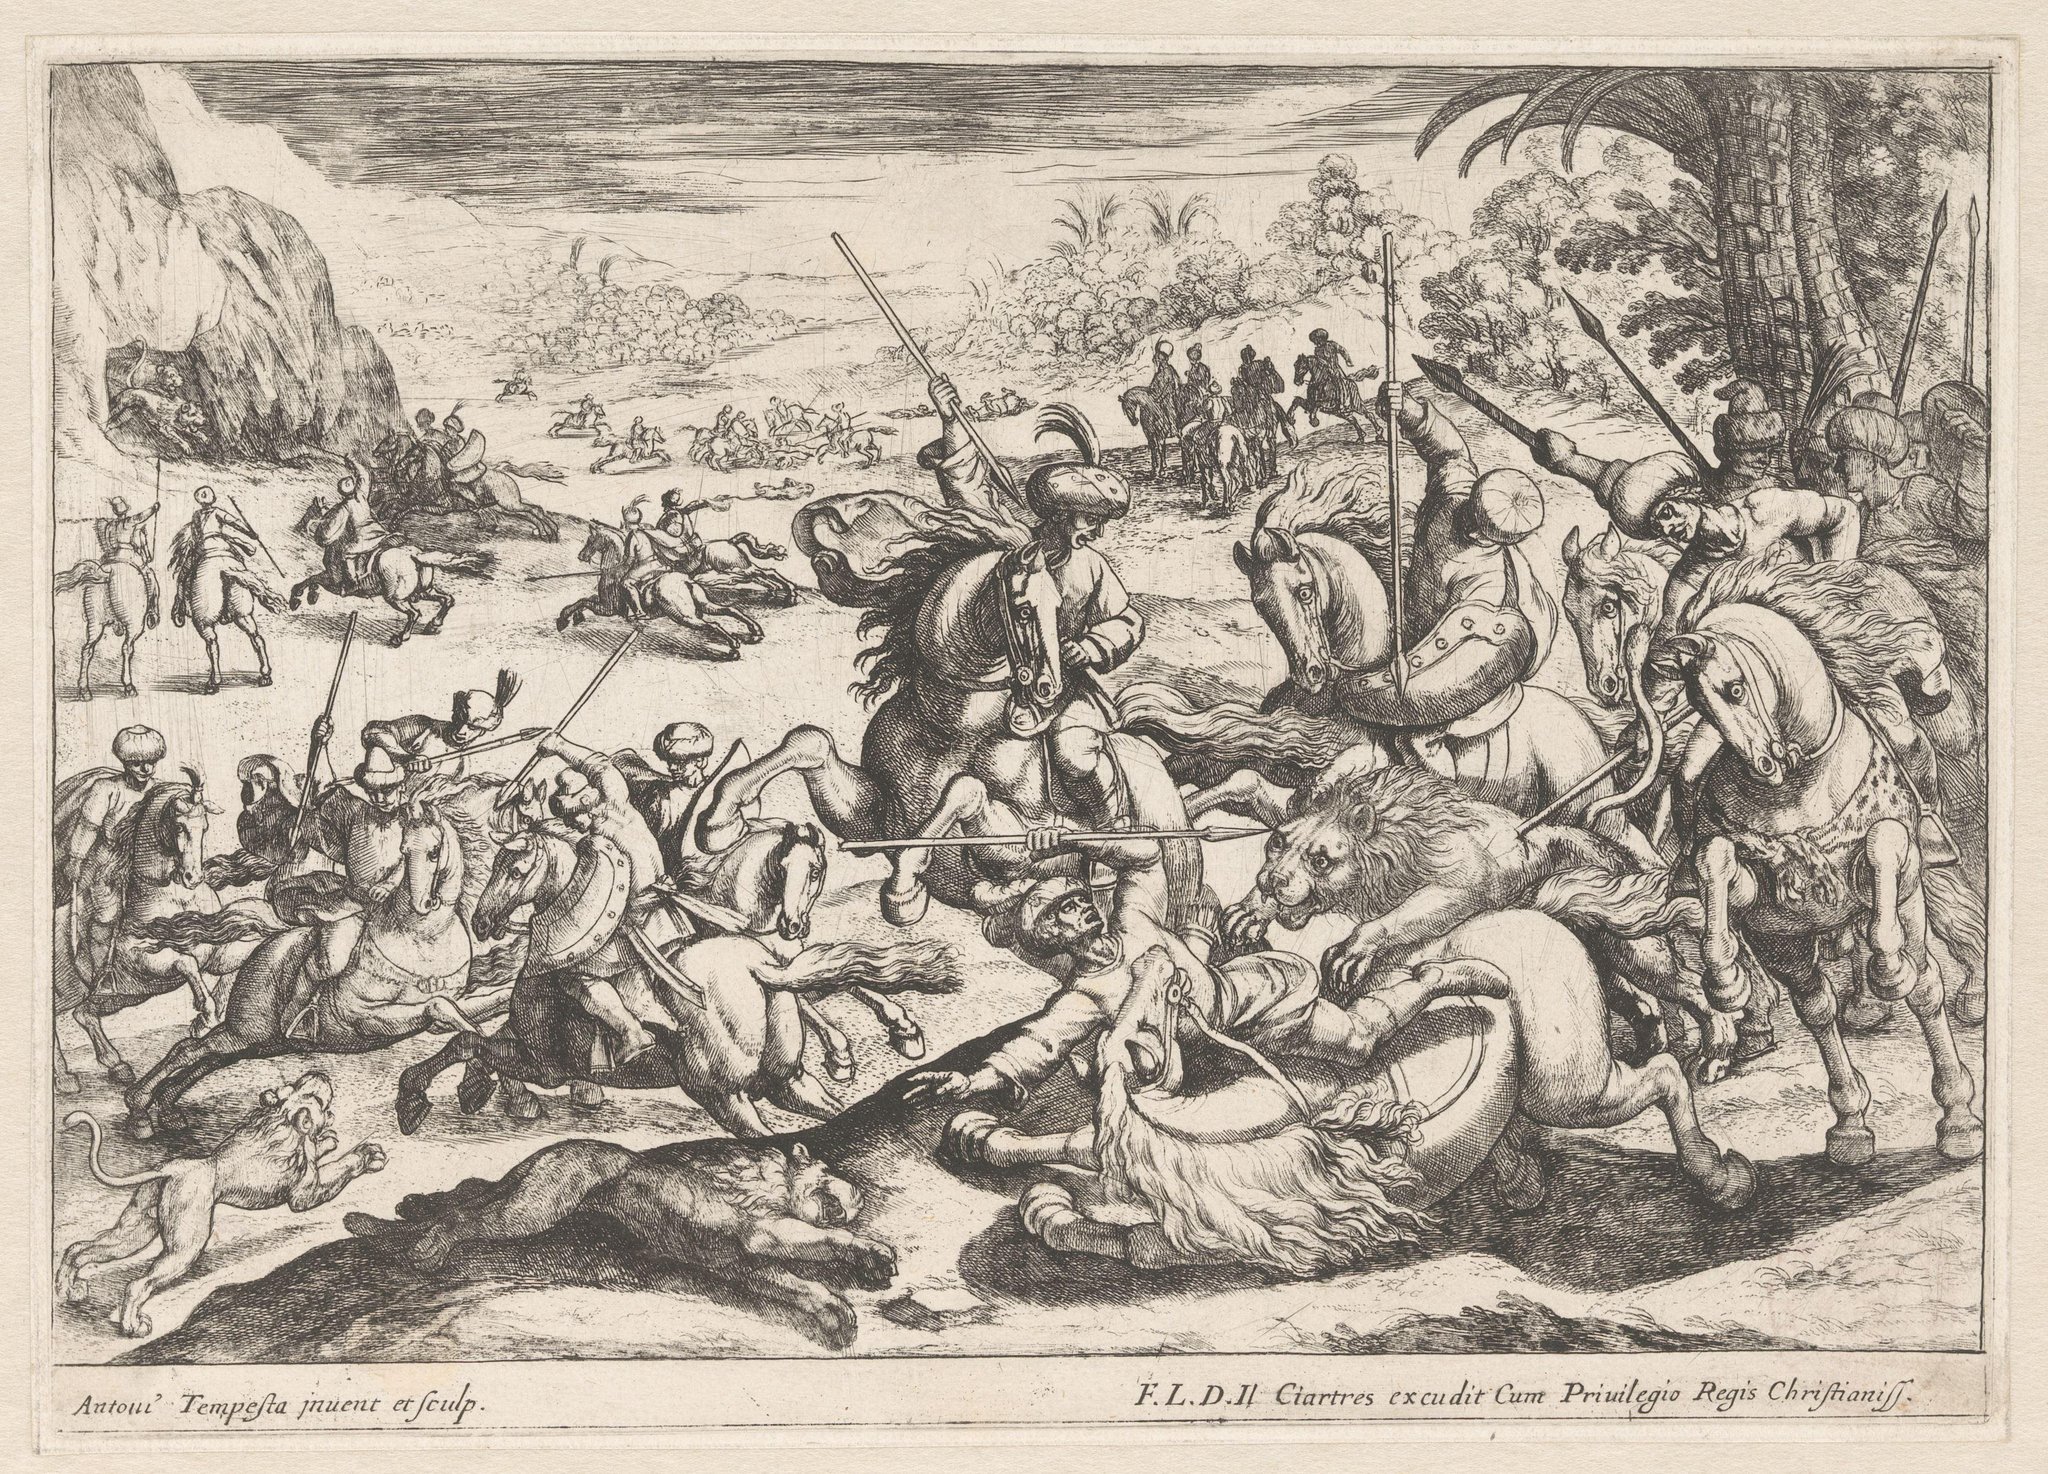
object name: print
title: Jachtscènes (deel 5)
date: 1600-1620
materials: paper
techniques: etching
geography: vatican city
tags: hunter fighting a lion, lion hunt, hunter, hunters hunting (n.b.: in 1988-1990 this notation denoted the concept of 43c11421 'hunters resting during the hunt')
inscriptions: collector's mark: Lugt 240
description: Deze prent maakt deel uit van een reeks van zeven prenten met jachtscènes.